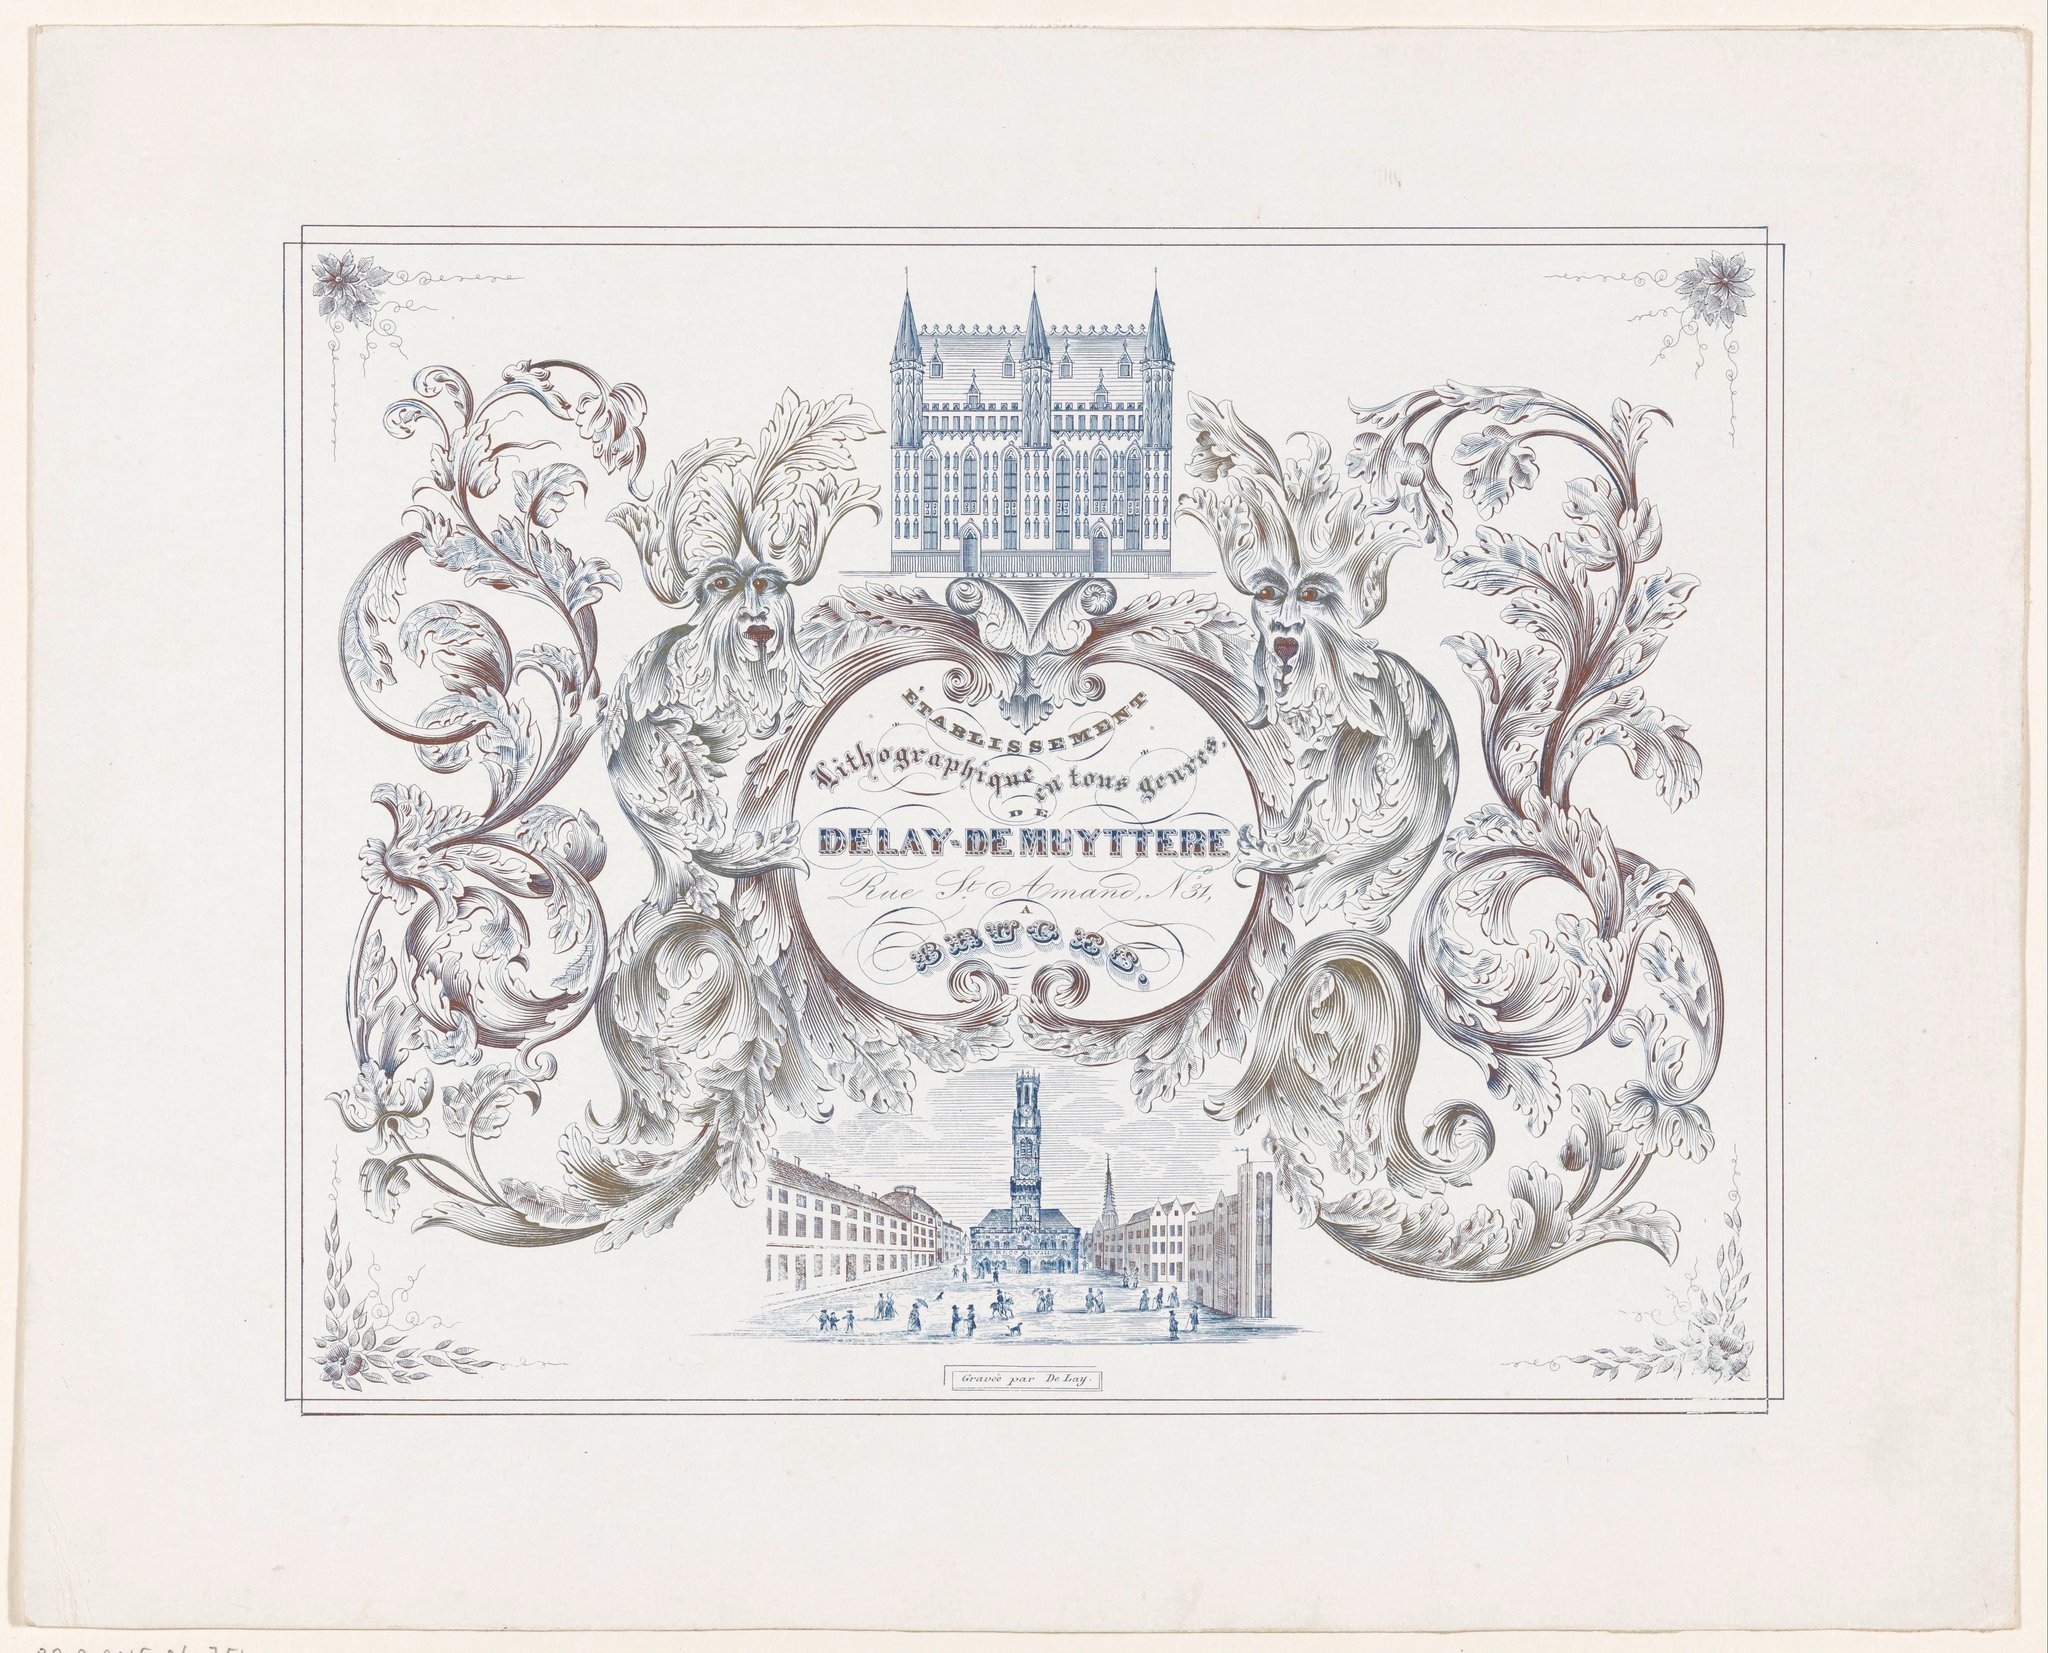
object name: advertising card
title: Reclamekaart van drukker Édouard De Lay-De Muyttere te Brugge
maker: édouard de lay-de muyttere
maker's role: print maker, printer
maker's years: 1816-1857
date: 1842-1855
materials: porcelainized cardboard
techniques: lithograph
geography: bruges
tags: anthropomorphic ornament, acanthus ~ ornament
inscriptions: collector's mark: Lugt 4780, collector's mark: Lugt 2228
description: Omlijsting van acanthusbladeren die rond de tekst de vorm aan heeft genomen van twee fantasiefiguren. Boven het stadhuis van Brugge, onder het Belfort.